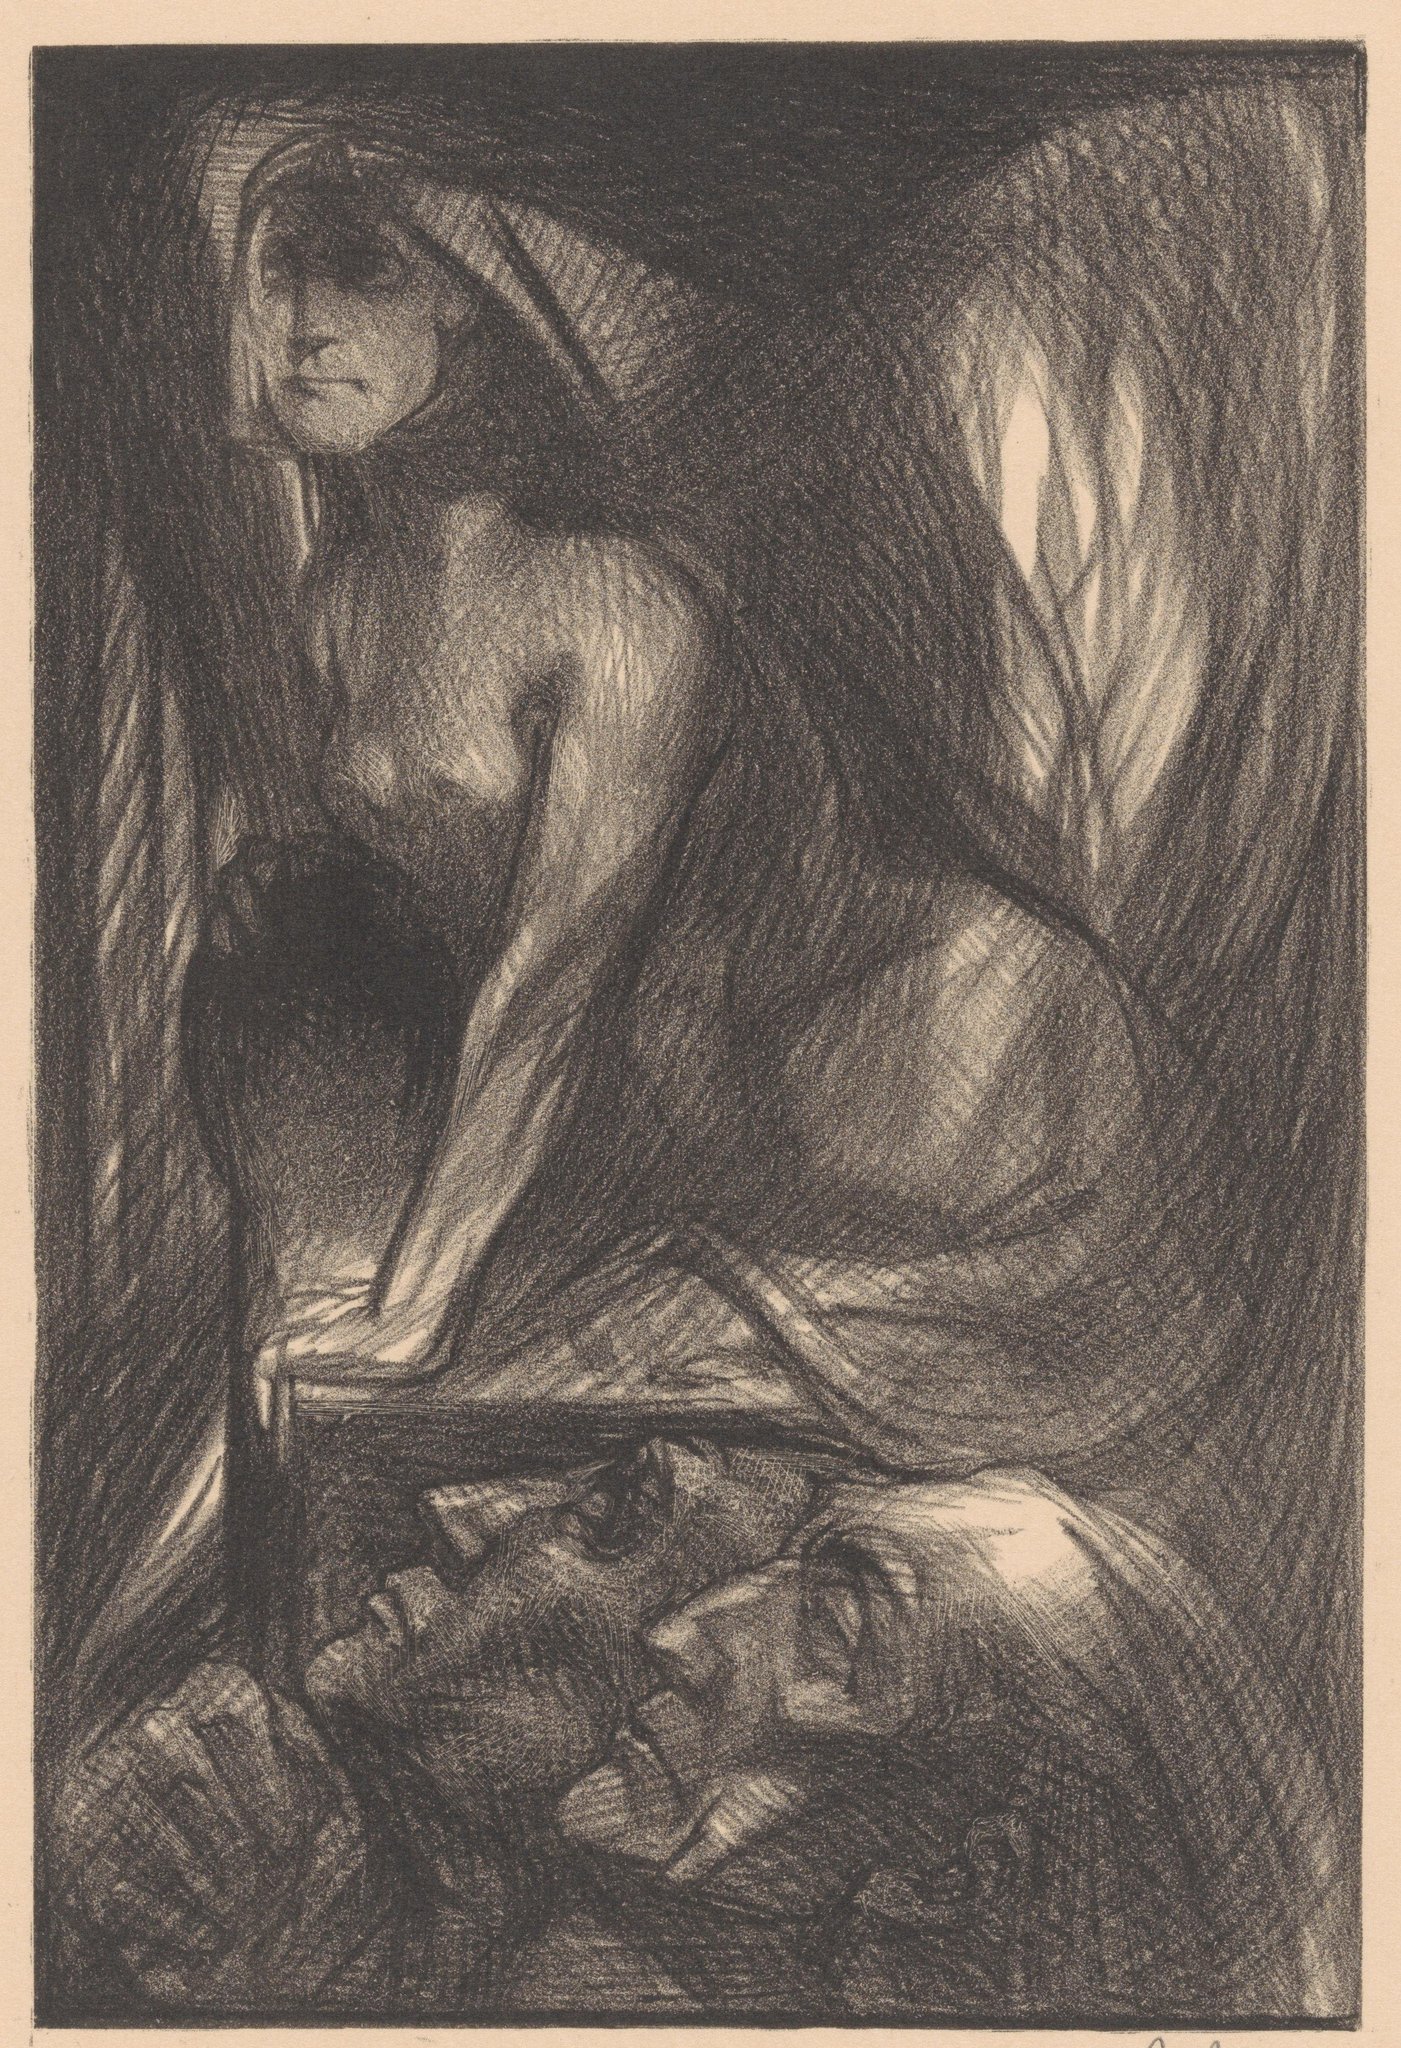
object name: print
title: Zittende sfinx met twee figuren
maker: johannes josephus aarts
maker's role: draughtsman, print maker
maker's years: 1871-1934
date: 1881-1931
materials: paper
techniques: lithograph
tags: sphinx (lion/woman); 'sfinge' (ripa)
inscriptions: collector's mark: Lugt 2228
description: Een zittende sfinx, met vrouwenhoofd, vleugels en staart. Voor haar de hoofden van twee figuren.